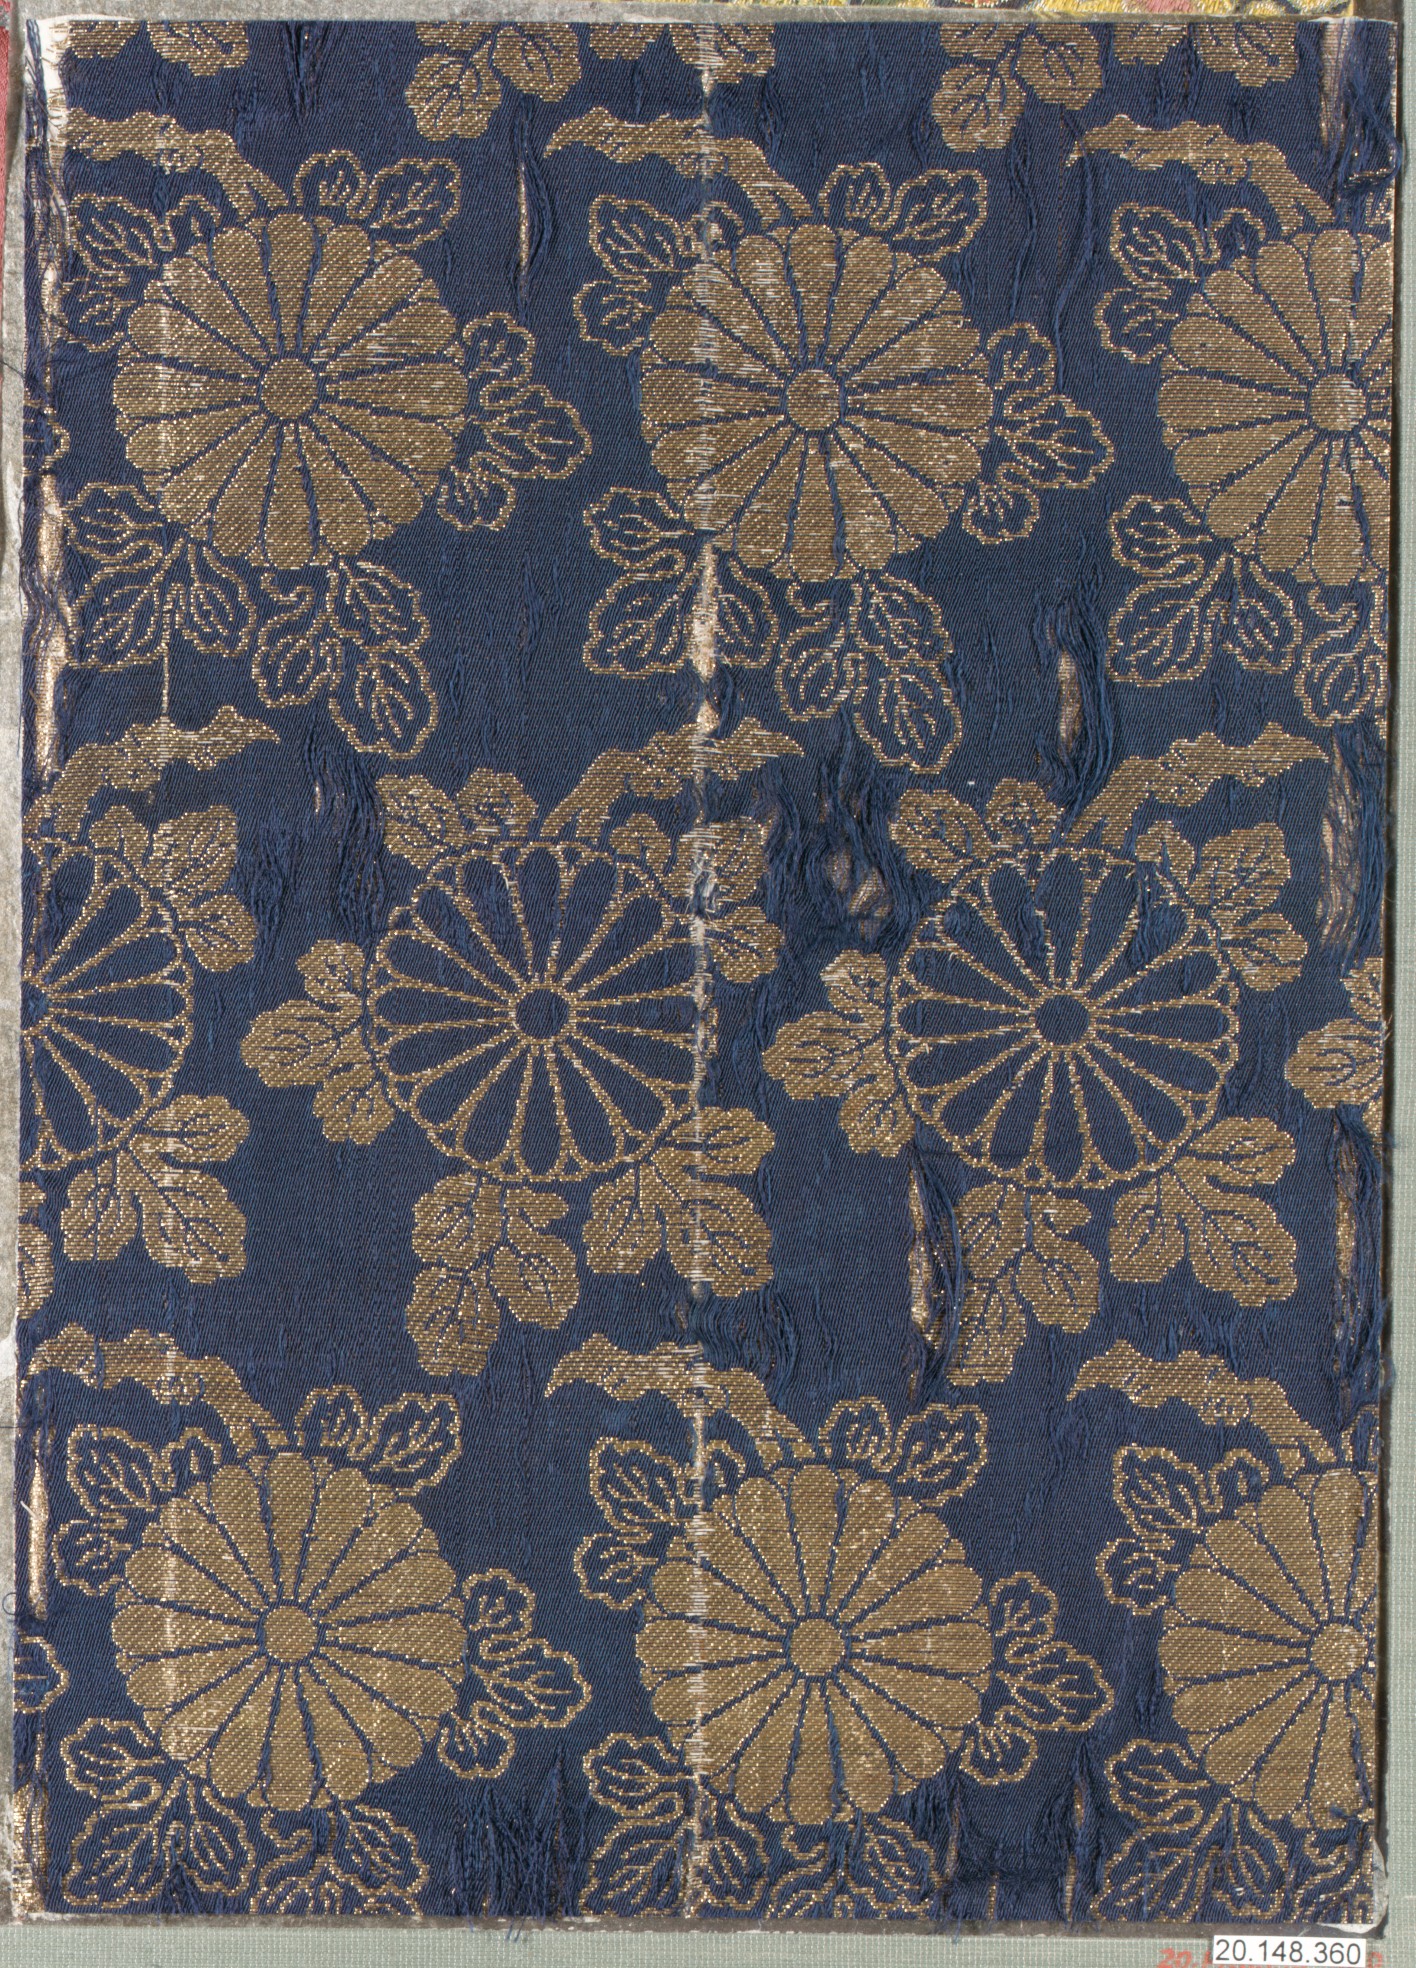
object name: piece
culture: japanese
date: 1701-1800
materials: silk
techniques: compound weave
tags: flowers,leaves